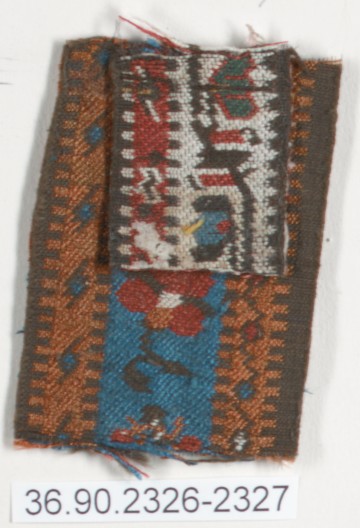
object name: border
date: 1801-1900